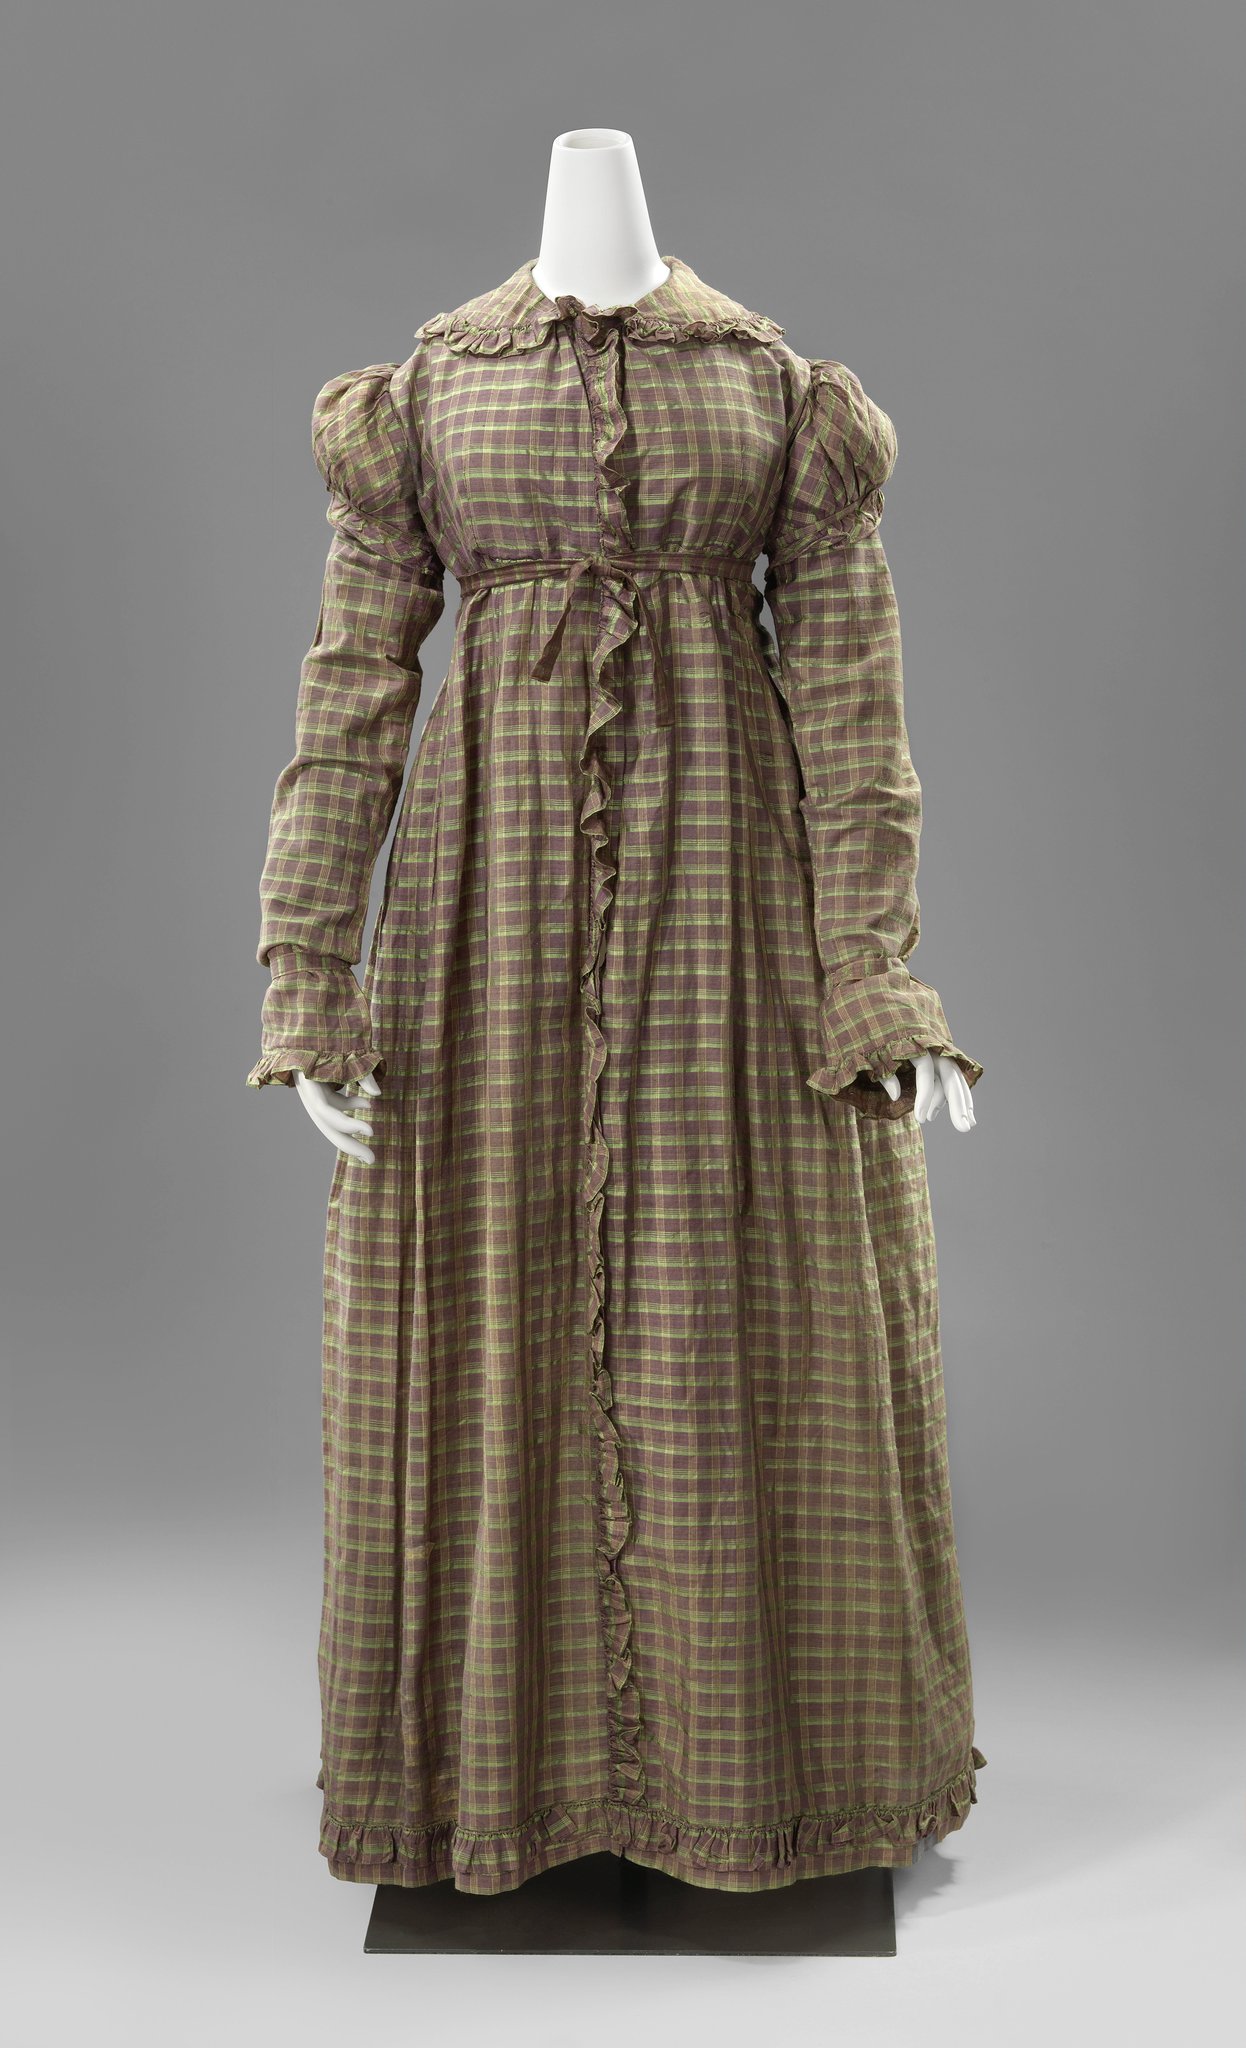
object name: robe, japon, jurk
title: Gown with a pleated back panel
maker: Anonymous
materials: cotton, silk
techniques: weave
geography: netherlands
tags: amsterdam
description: This dress clearly illustrates the changing shape of the back panels of the bodice. Where previously they still had a diamond-shaped insert, here the back is pleated into shape. The sleeve inset is still far back on the shoulder. The flat, round collar of this dress, the dark colours and the lozenge all point to the 1820s.